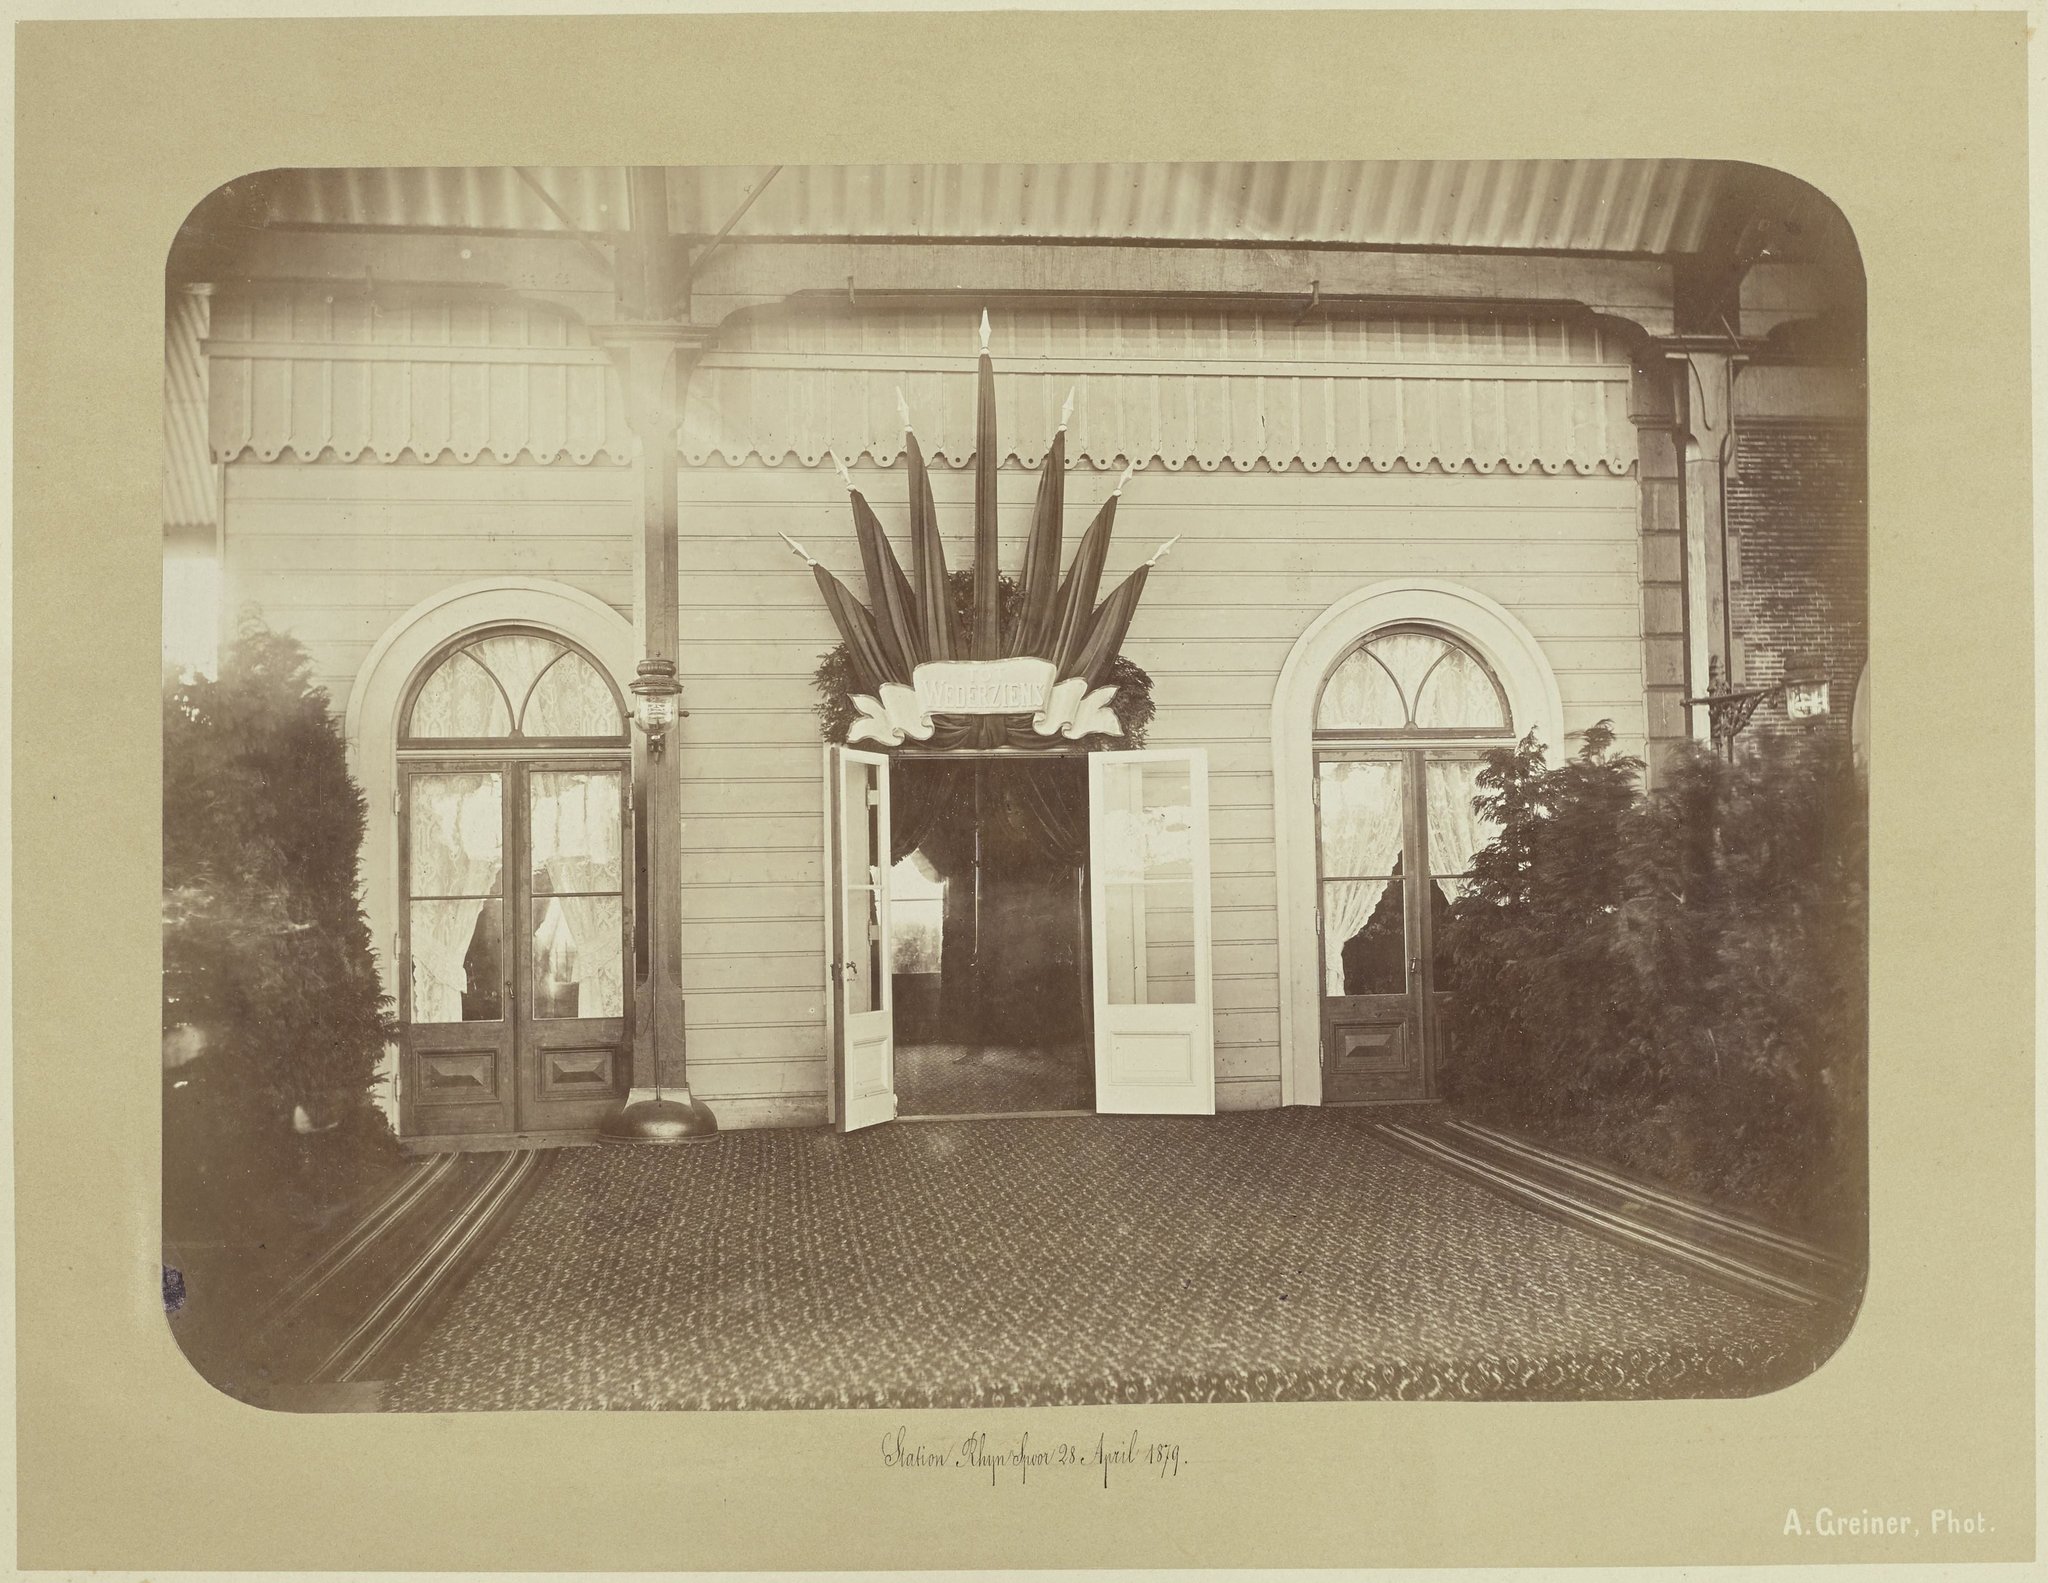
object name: photograph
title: Versieringen ter gelegenheid van het bezoek van koning Willem III en koningin Emma aan Amsterdam, 1879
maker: albert greiner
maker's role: fotograaf, fotostudio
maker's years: 1833-1890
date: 1879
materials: cardboard, paper, photographic support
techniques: albumen print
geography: amsterdam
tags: the hague, emma (queen consort of the netherlands), brussels, willem iii (koning der nederlanden), visiting; receiving guests; elegant company, station; shelter (railway, tramway), decorations, honours (as symbols of the state, etc.)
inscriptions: inscription: ‘Station Rhijn Spoor 28 April 1879.’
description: Versierde toegang tot Station Rijnspoor bij het vertrek van Willem en Emma uit Amsterdam op 28 april 1879. Onderdeel van een serie van tien foto's van de versieringen aangebracht in de stad ter gelegenheid van het bezoek van koning Willem III en zijn tweede echtgenote Emma aan Amsterdam op 21 april 1879.